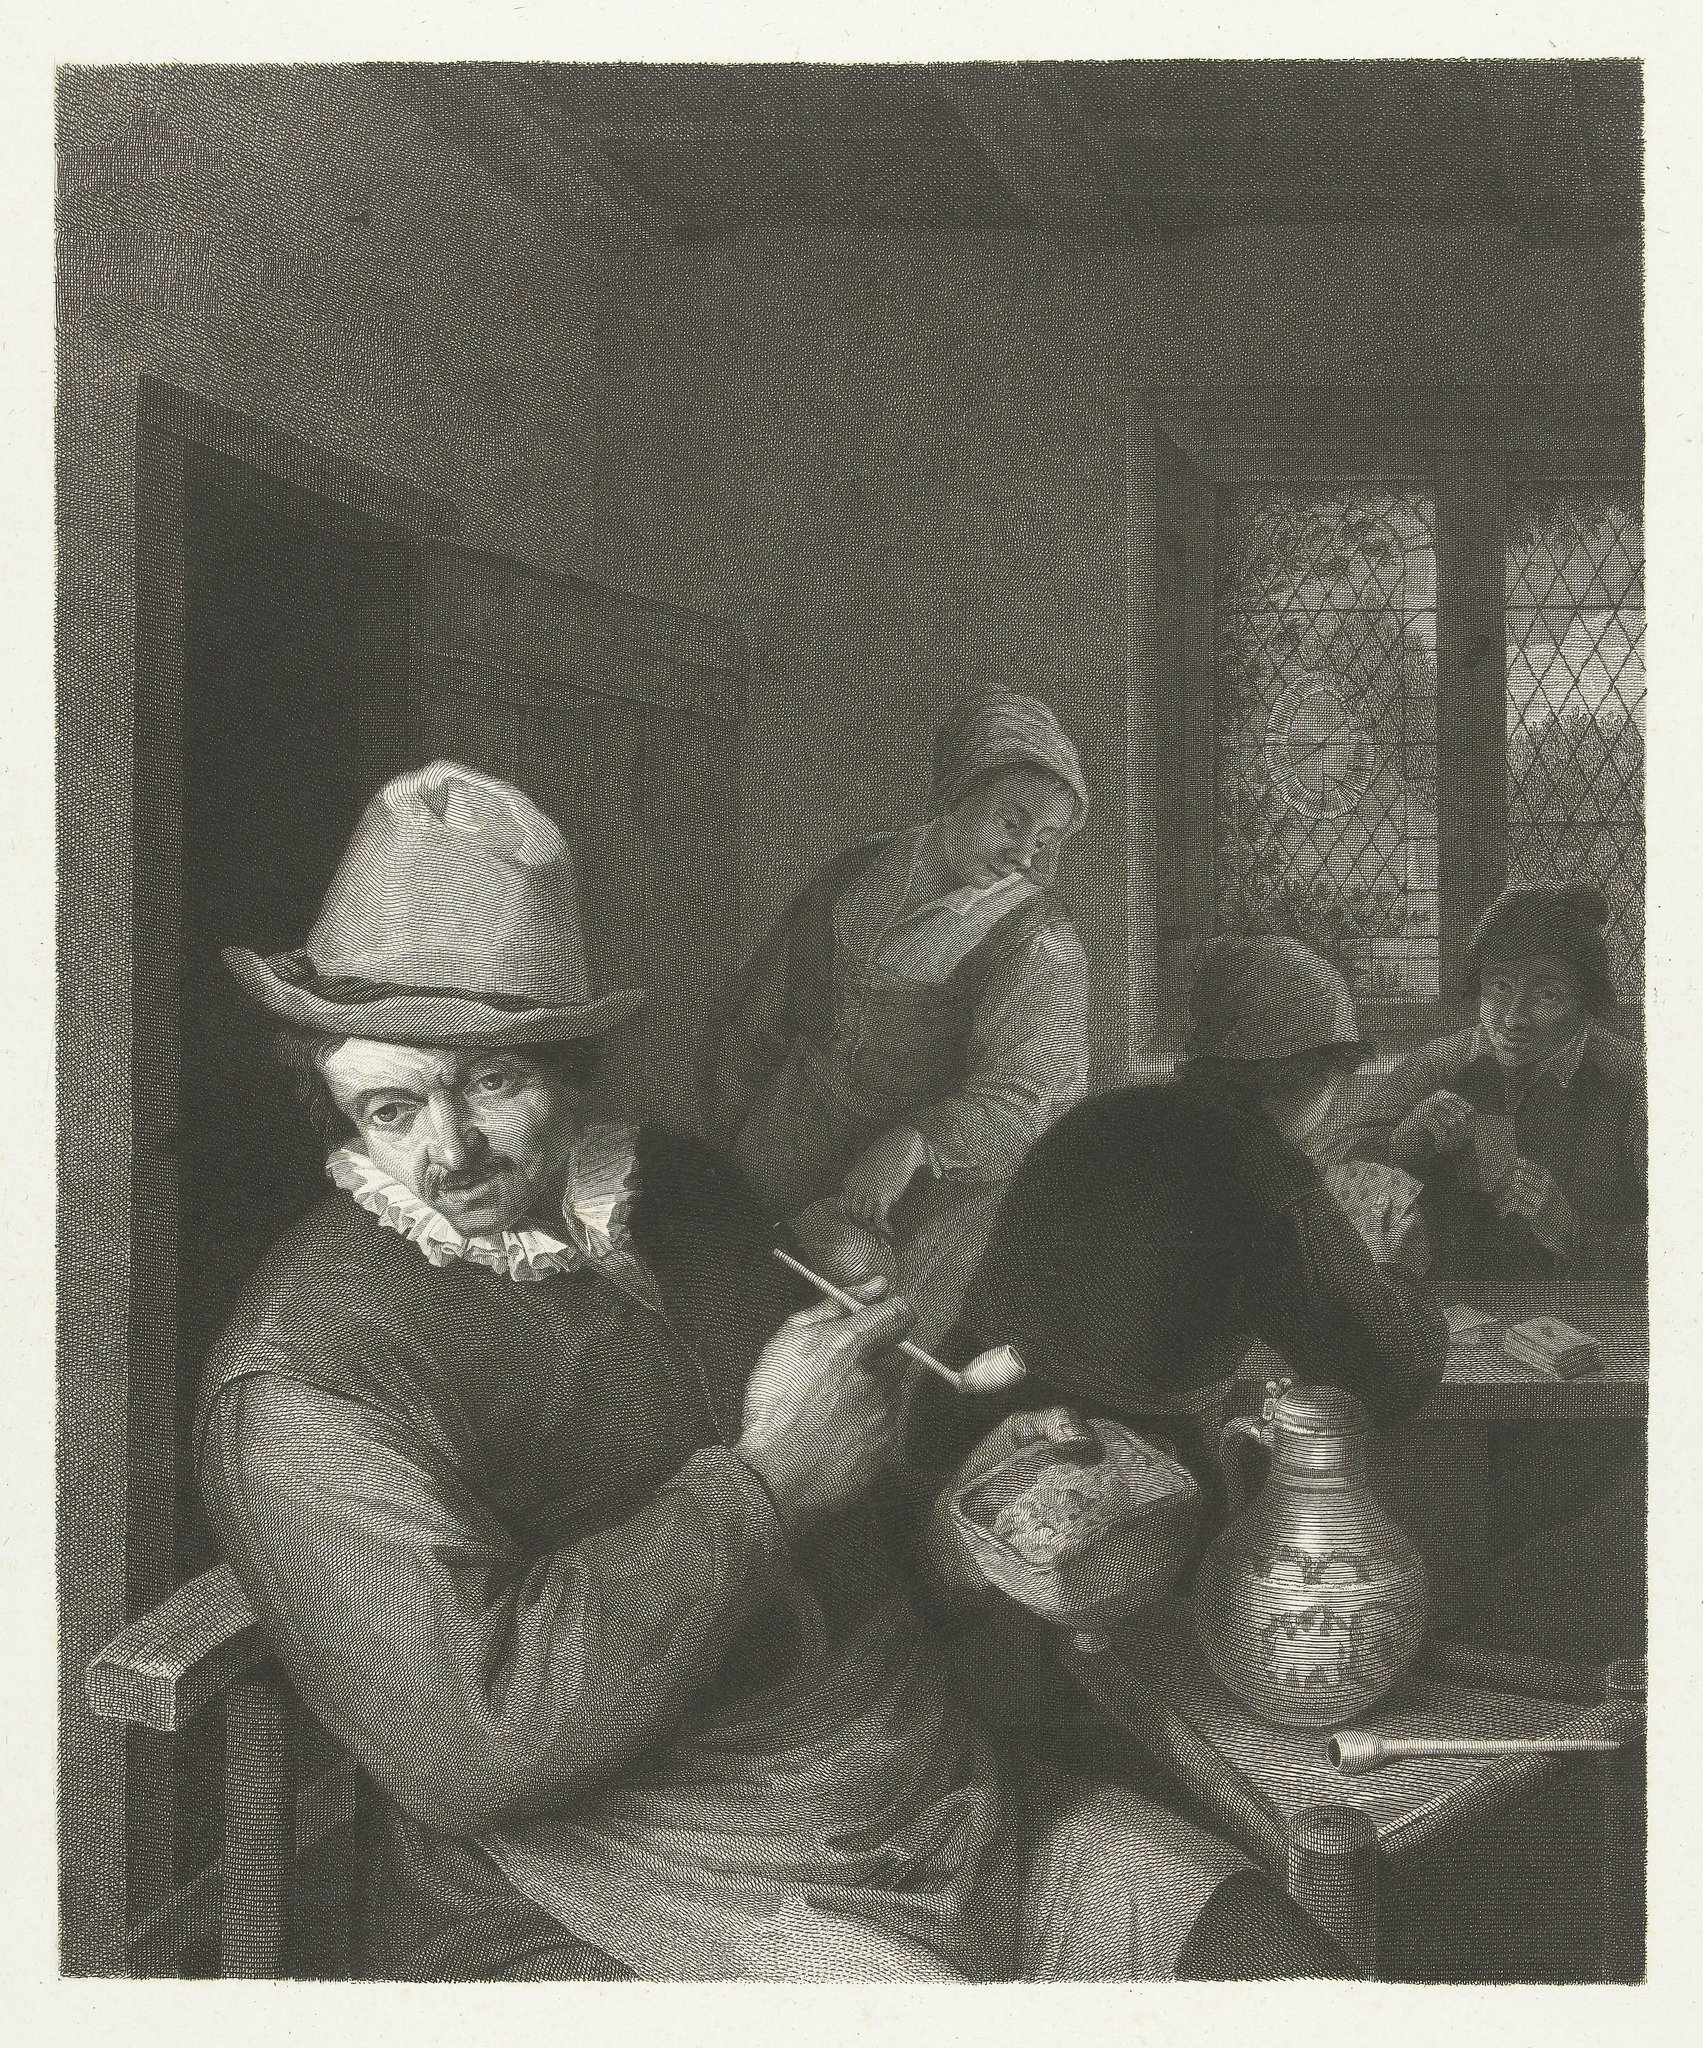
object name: print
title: Kroegscène met man die een pijp stopt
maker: lambertus antonius claessens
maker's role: draughtsman, print maker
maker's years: 1763-1834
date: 1823-1834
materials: paper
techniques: engraving, etching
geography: paris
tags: pipe ~ tobacco (+ taking (particular) foodstuffs: eating, drinking, smoking, chewing, etc.), inn, coffee-house, public house, etc. (+ ordering ~ indoor recreation)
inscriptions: collector's mark: Lugt 2228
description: Gemaakt voor: Musée français : recueil des plus beaux tableaux, statues et bas-reliefs qui existaient au Louvre avant 1815, avec l'explication des sujets, et des discours historiques sur la peinture, la sculpture et la gravure. Paris: A. & W. Galignani & Londers, J.O. Robinson, [1829-39], deel II.